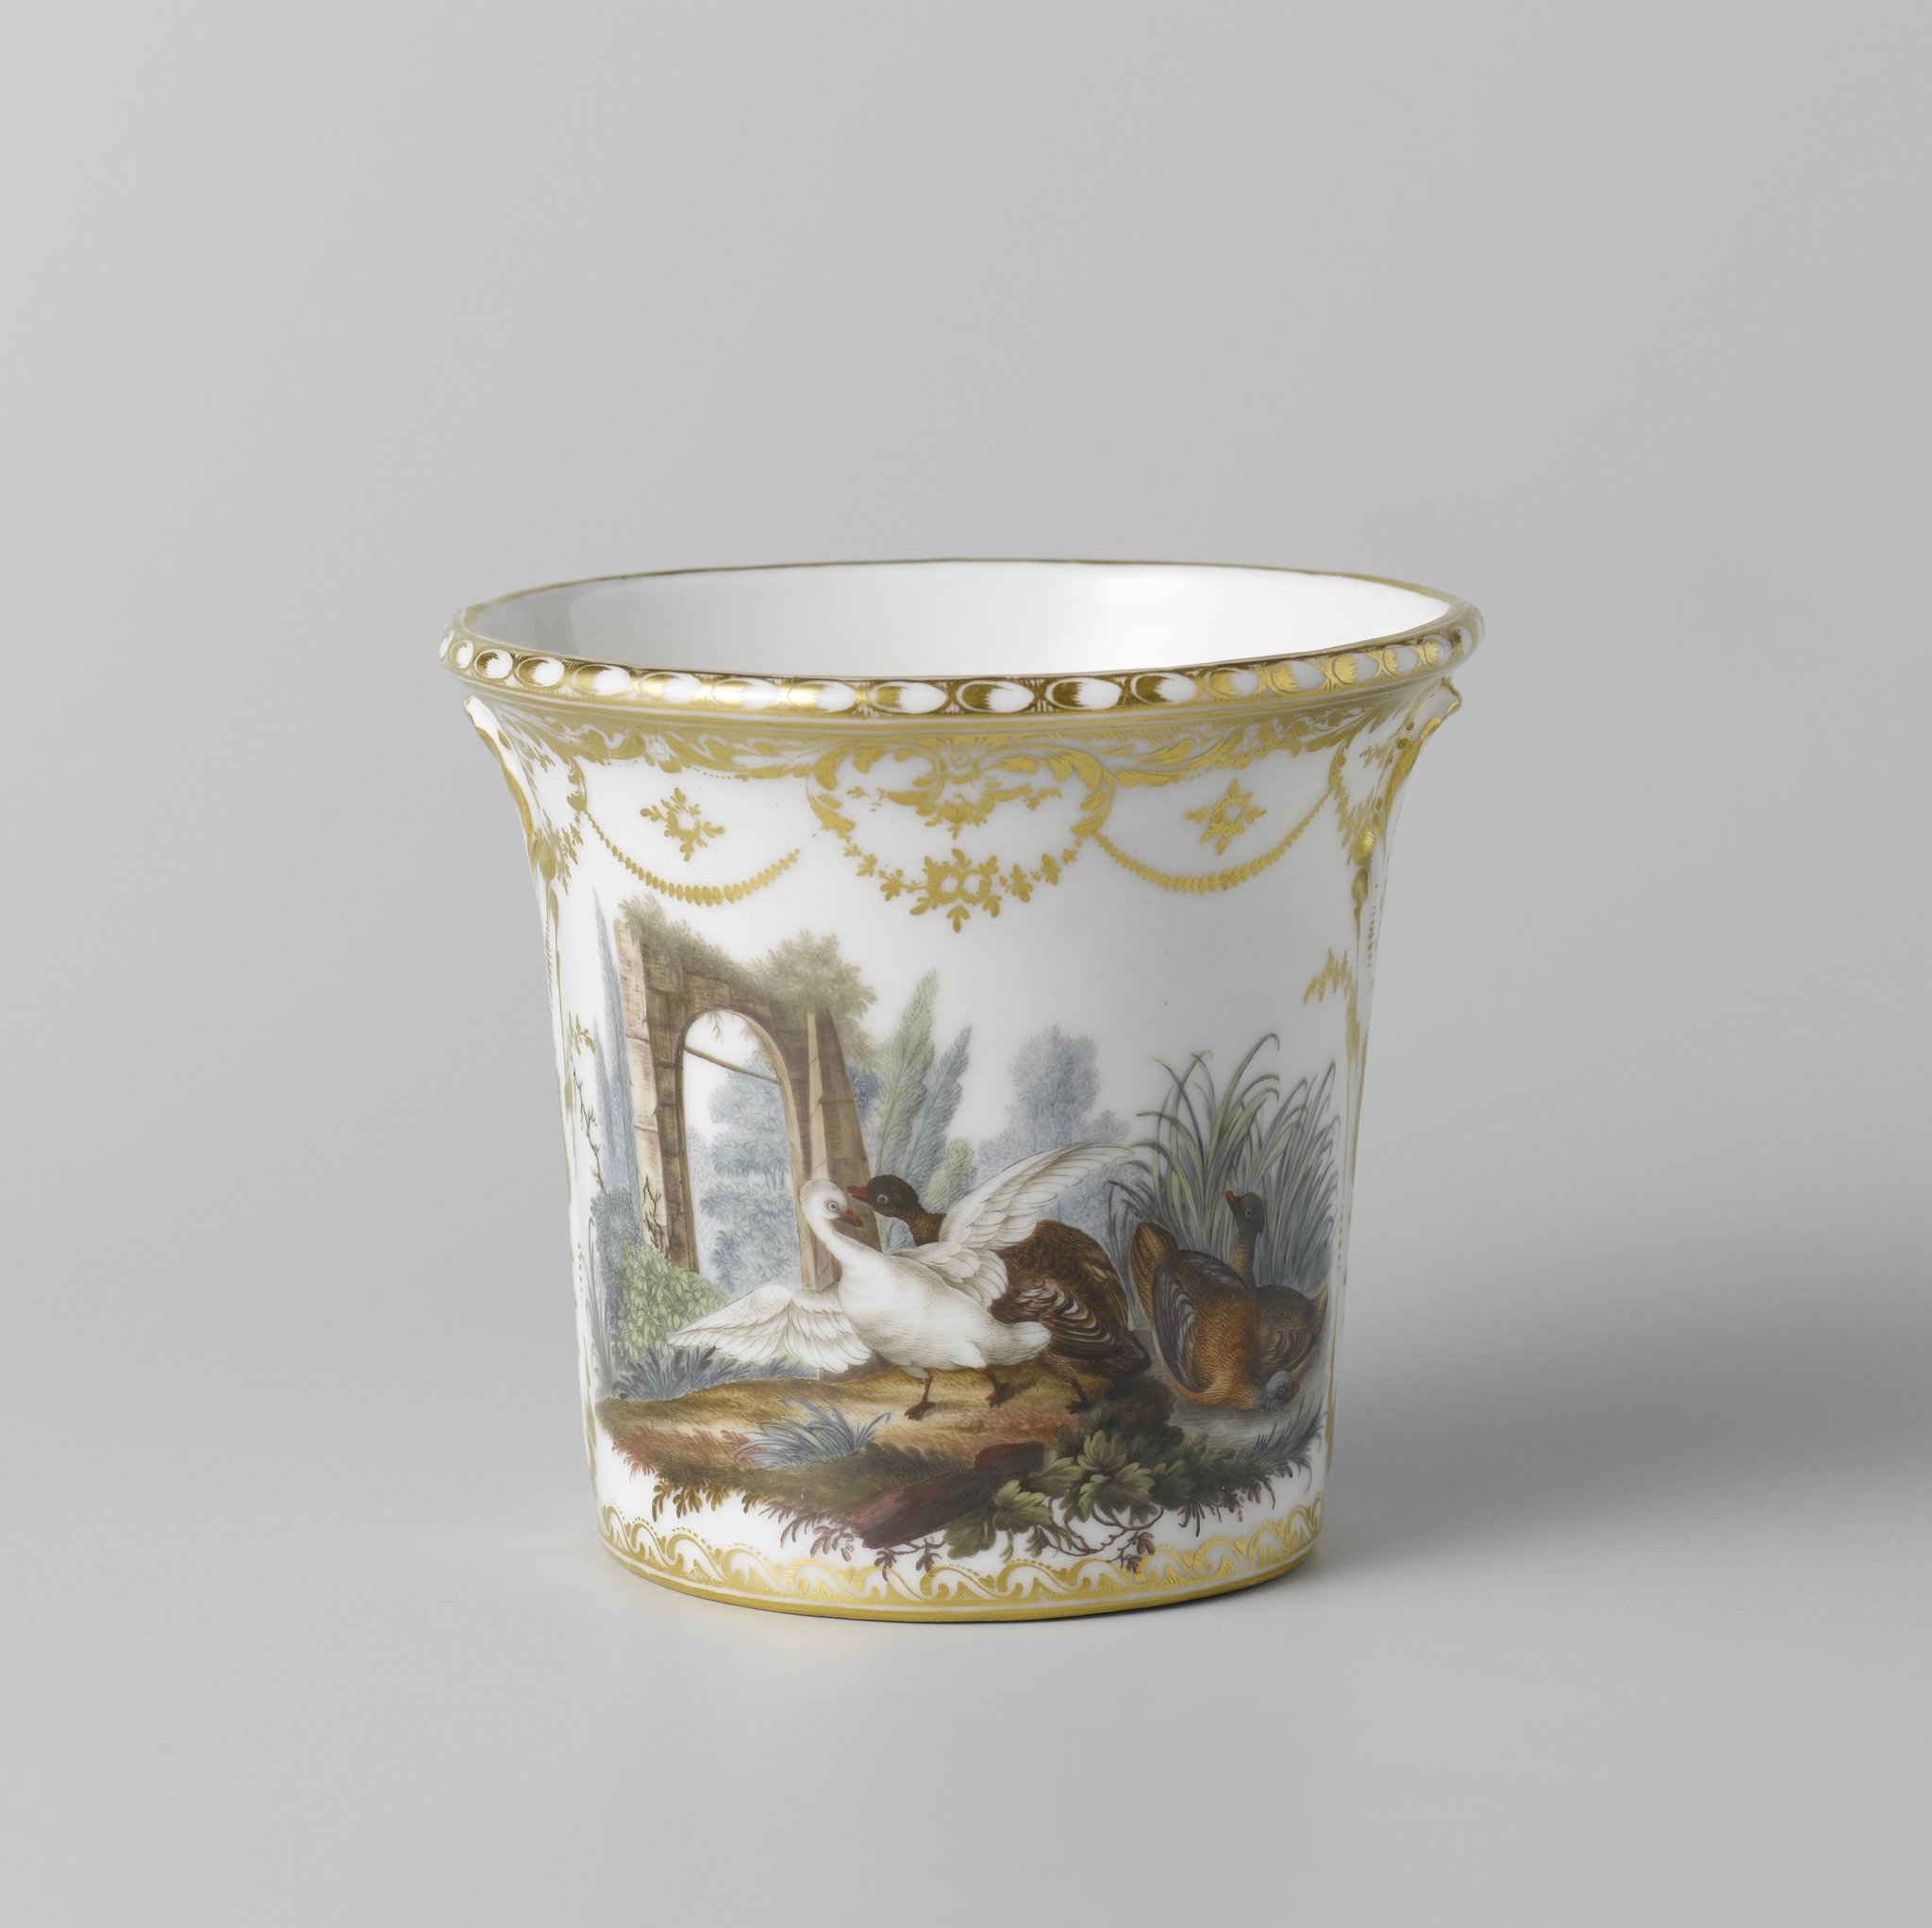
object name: cachepot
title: Three flowerpot containers (cache-pots) and stands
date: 1778-1782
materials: porcelain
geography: loosdrecht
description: Manufactuur Oud-Loosdrecht Loosdrecht, c. 1778–1782 hard-paste porcelain